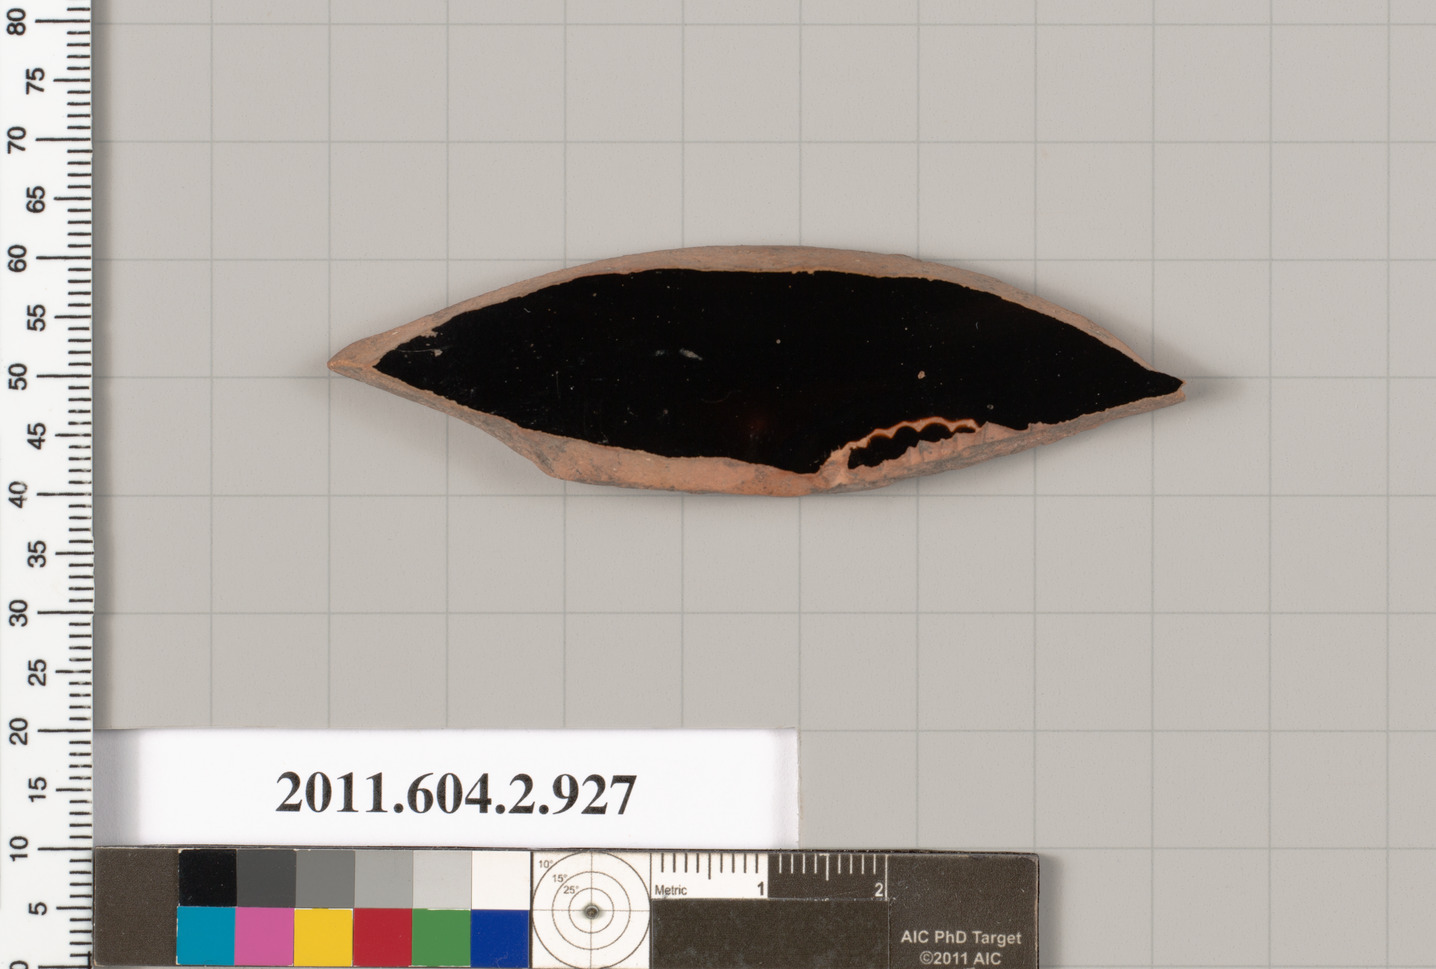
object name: kalpis fragment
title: Terracotta fragment of a hydria: kalpis (water jar)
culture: greek, attic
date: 475-451 BCE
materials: terracotta